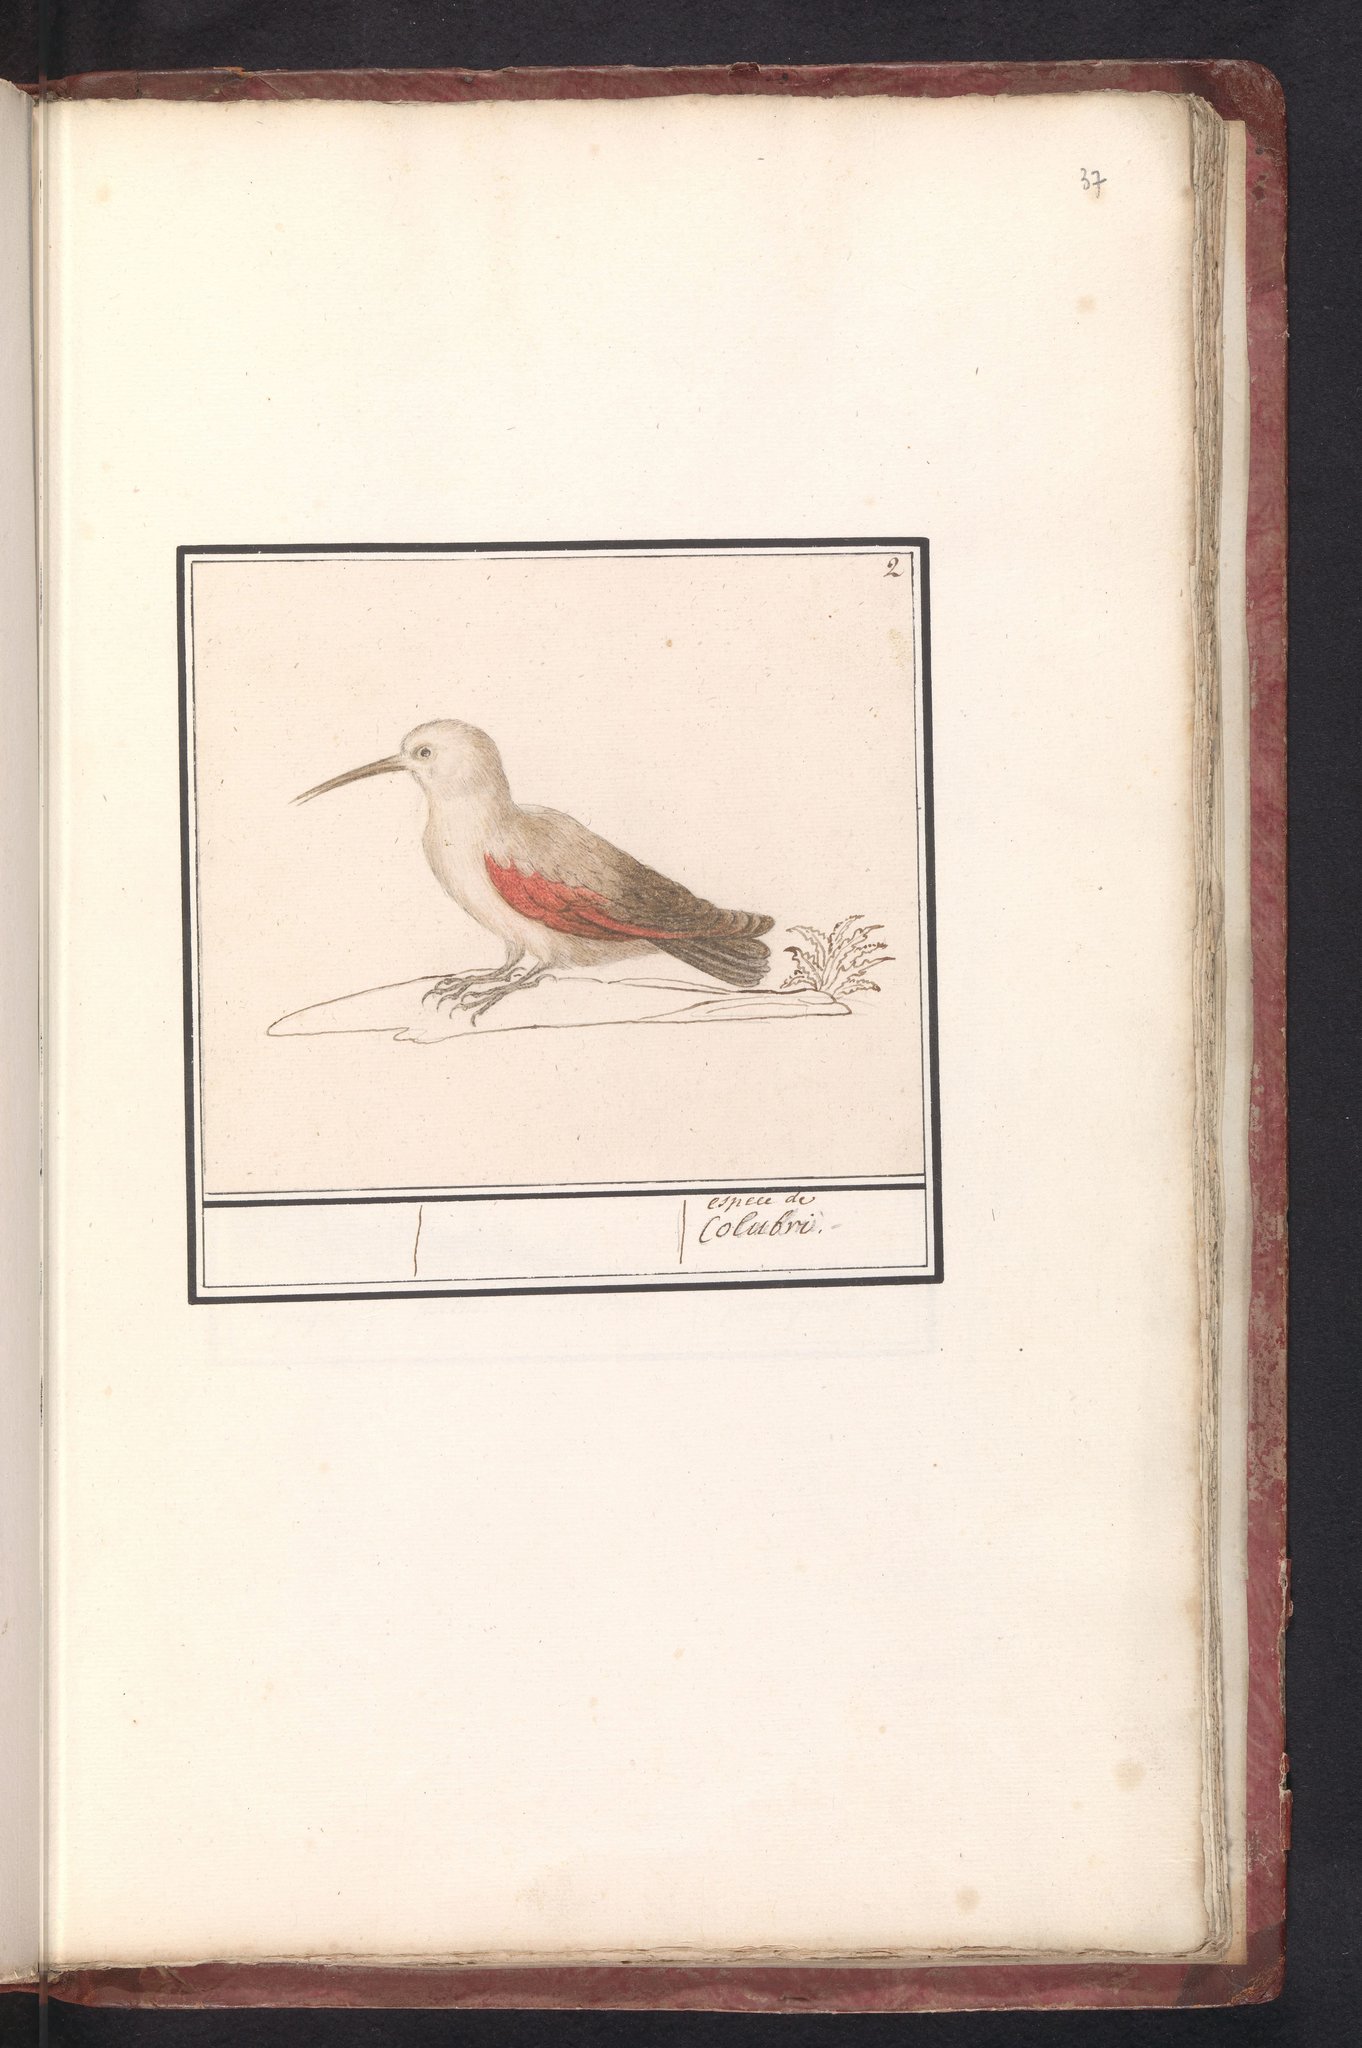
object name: drawing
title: Wallcreeper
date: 1596-1610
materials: paint, ink, paper, pencil, watercolor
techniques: brush, pen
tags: other birds: wall creeper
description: Rotskruiper. Genummerd rechtsboven: 2. Onderdeel van het tweede album met tekeningen van vogels. Vierde van twaalf albums met tekeningen van dieren, vogels en planten bekend rond 1600, gemaakt in opdracht van keizer Rudolf II. Met toelichting in Nederlands, Latijn en Frans.